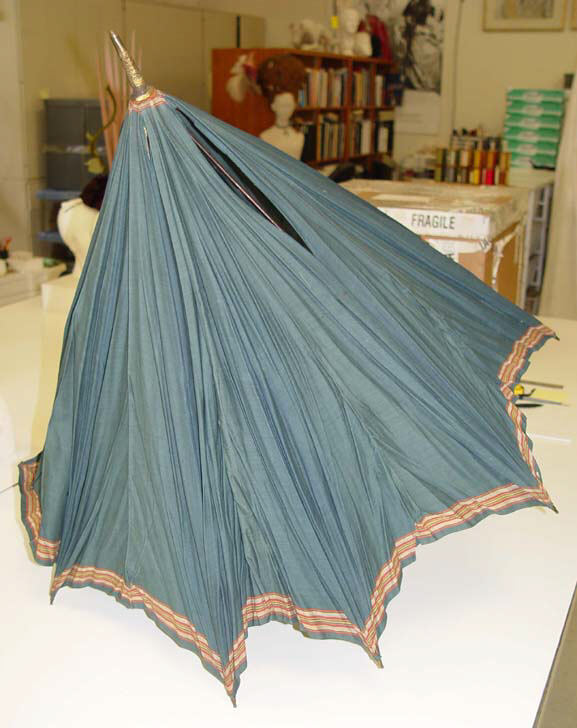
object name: umbrella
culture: british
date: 1801-1833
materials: metal, silk